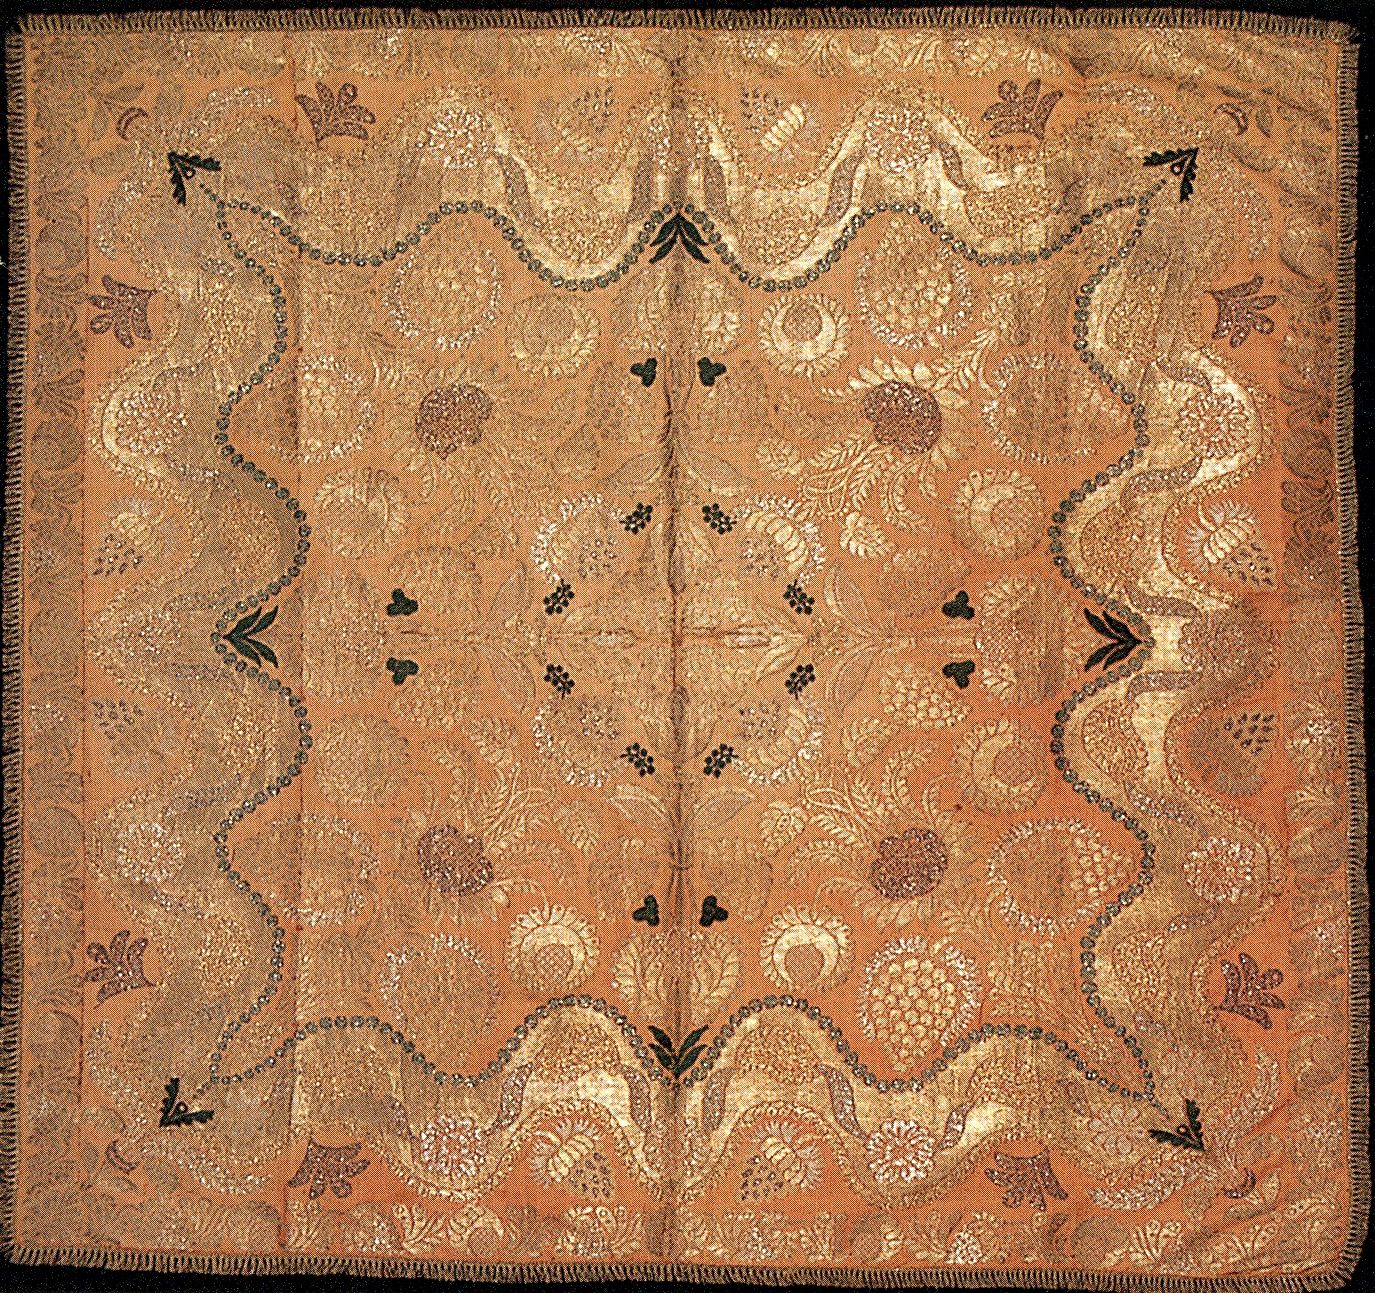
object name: textile cover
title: Cover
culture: russian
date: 1801-1900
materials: metal, silk